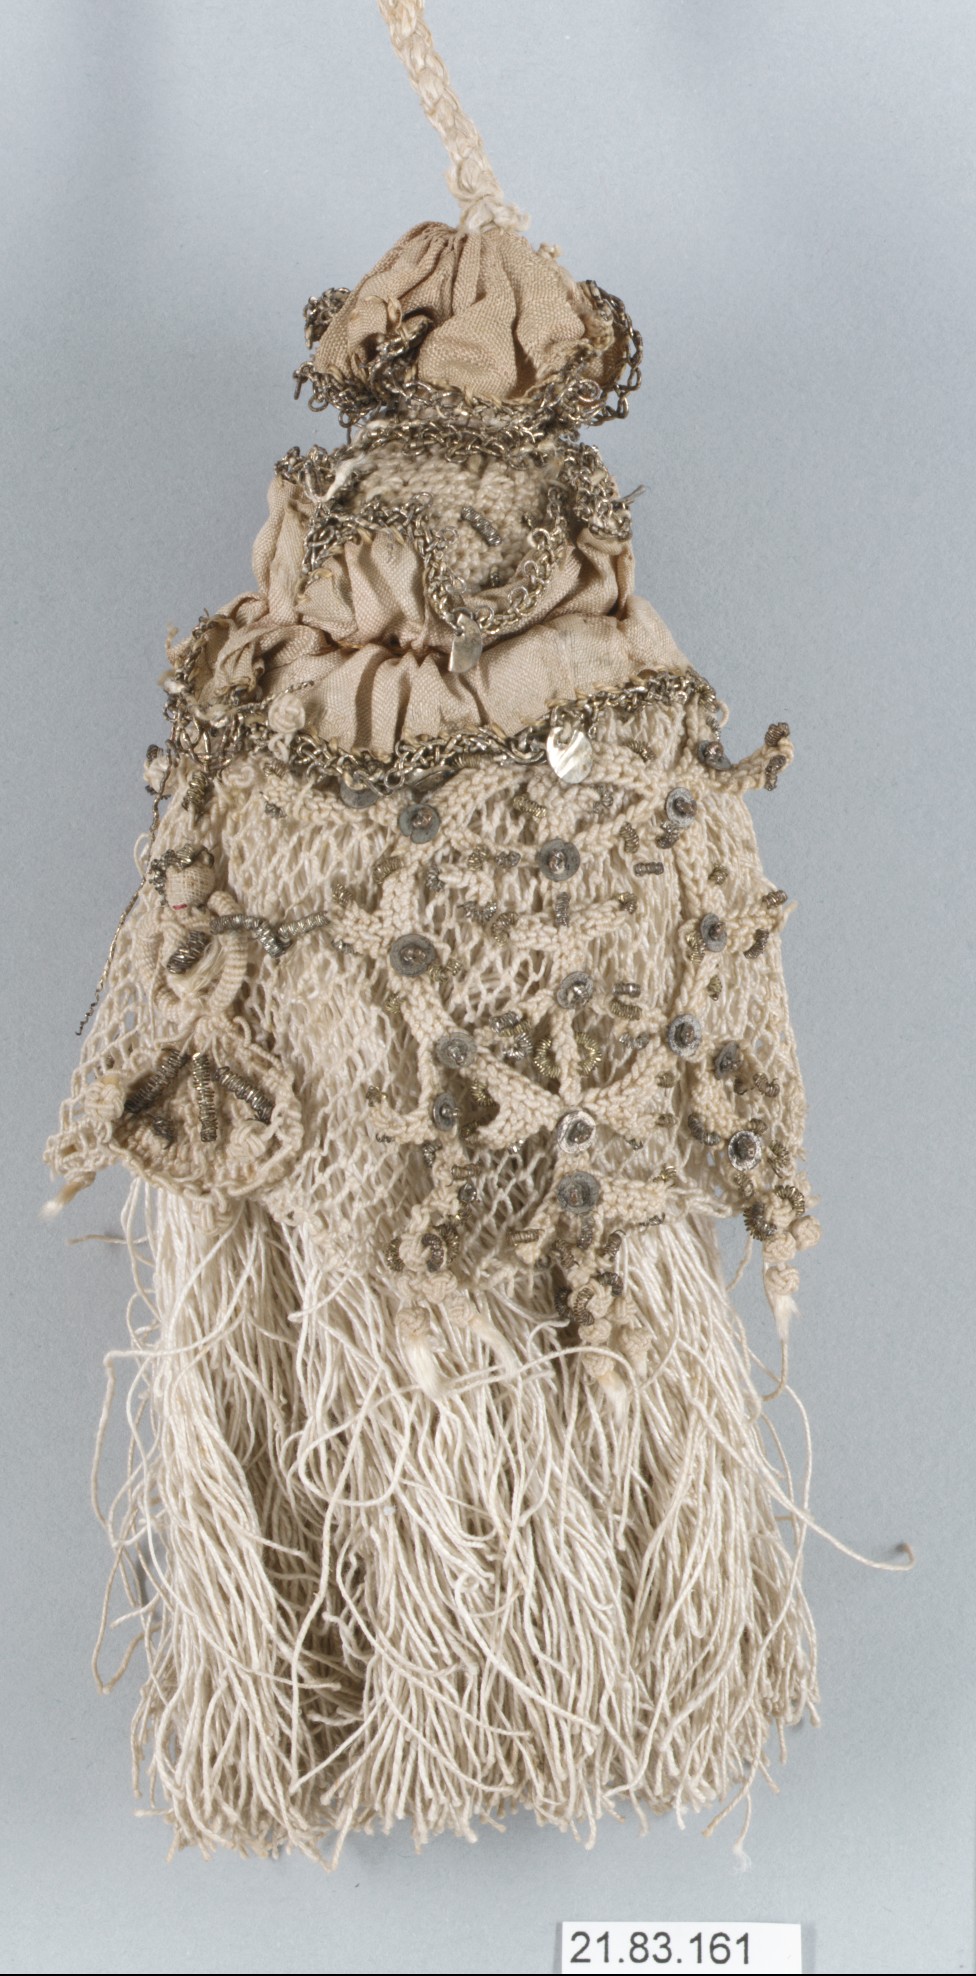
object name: tassel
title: Pair of tassels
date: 1601-1700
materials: linen, metal thread